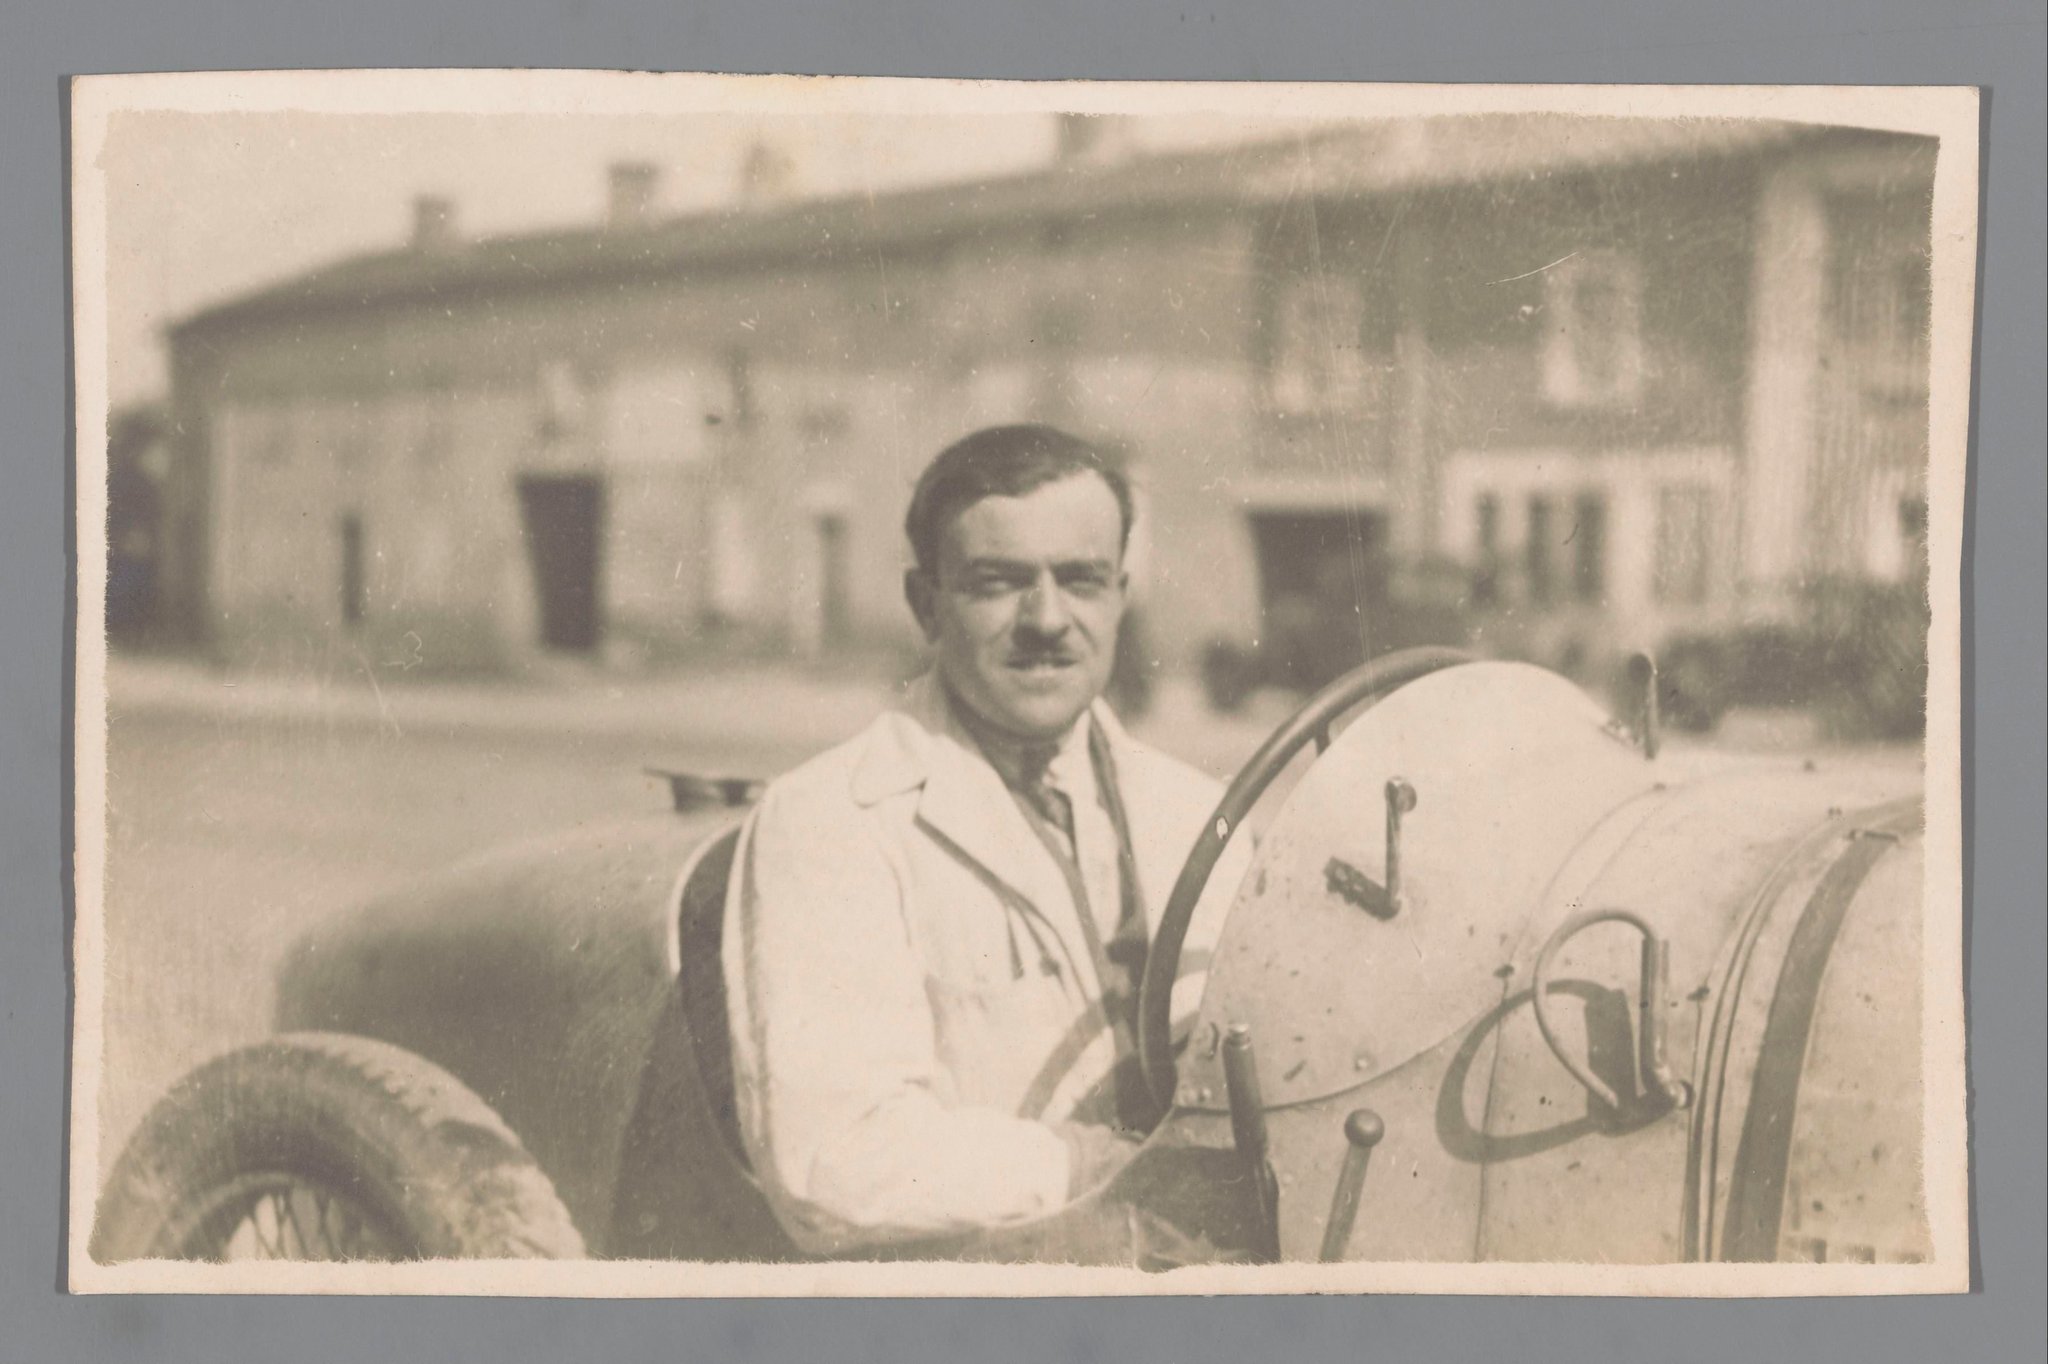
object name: photograph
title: Portret van een onbekende man in een raceauto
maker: Anonymous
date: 1915-1930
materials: photographic support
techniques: gelatin silver print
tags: adult man, automobile